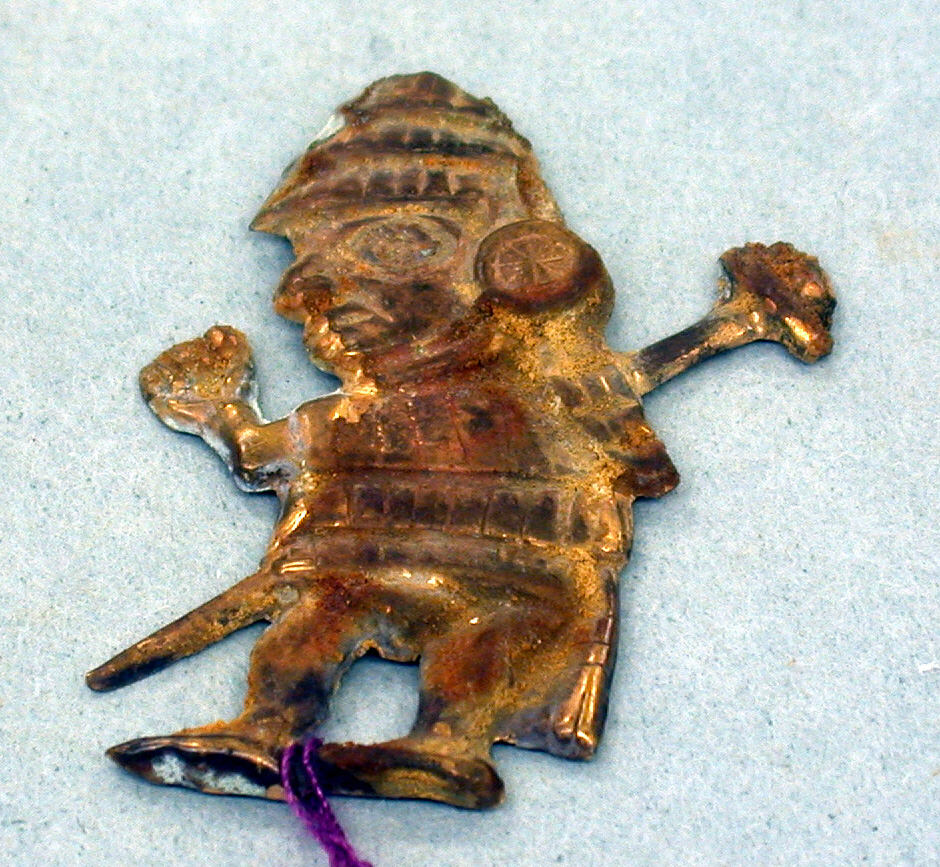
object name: ornament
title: Warrior Ornaments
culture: moche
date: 501-700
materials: gold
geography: peru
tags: human figures